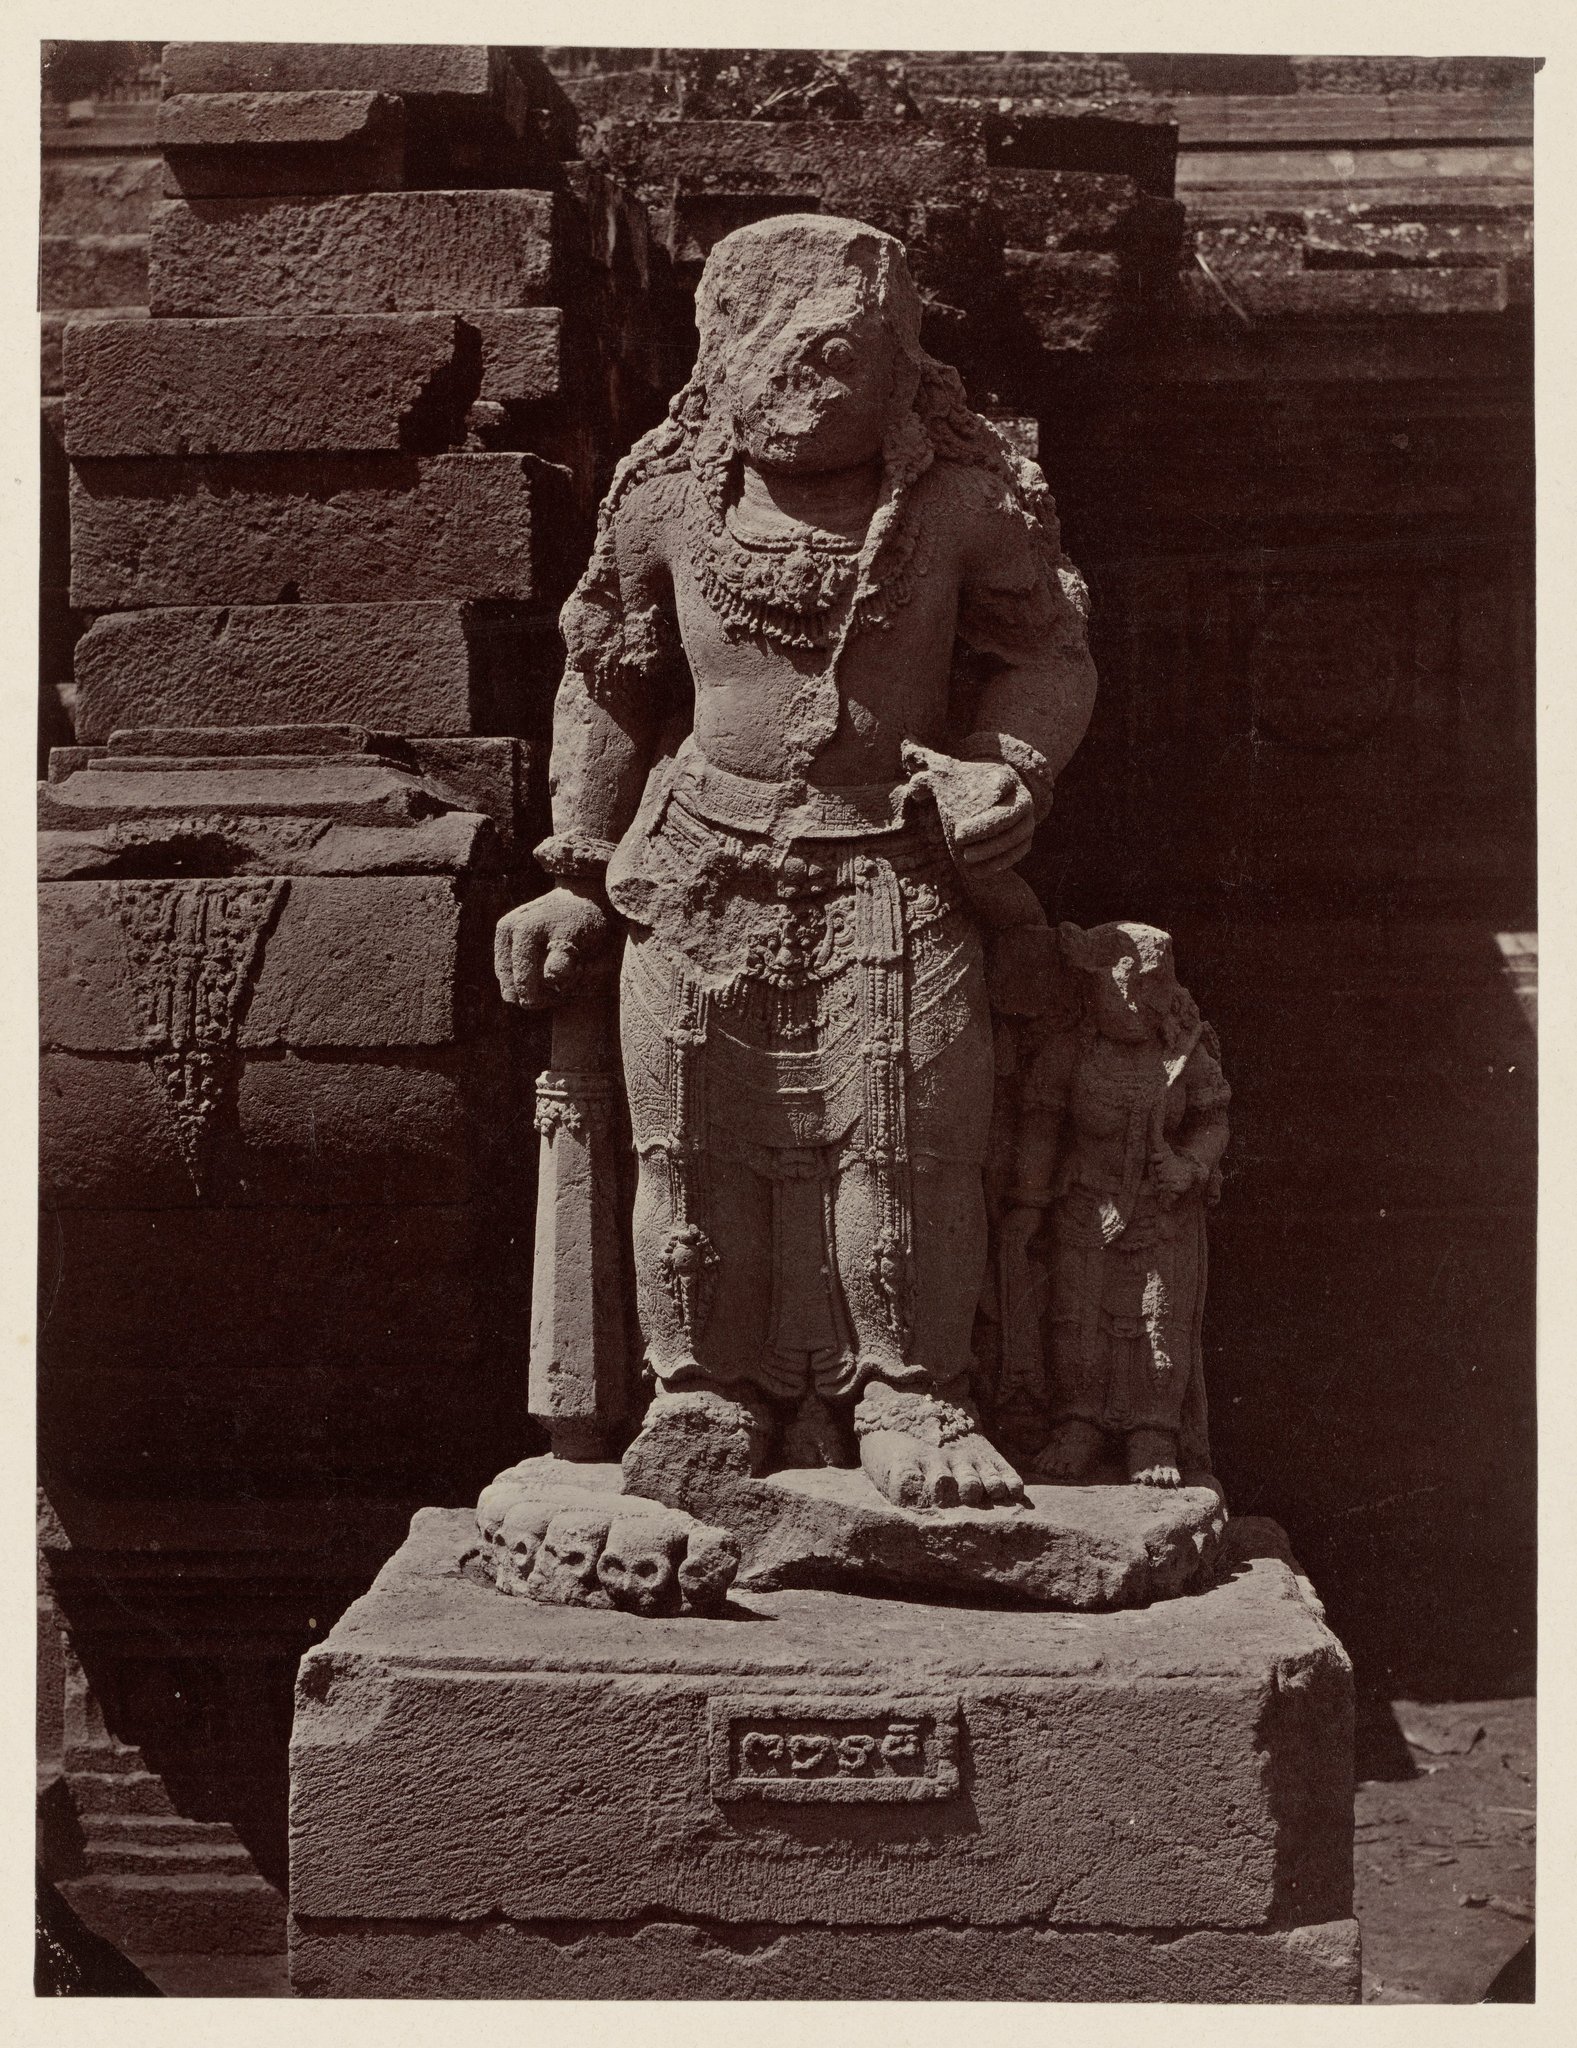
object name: photograph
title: Candi Panataran (Temple Complex), Main Temple; dated dvarapala (with female attendant) guarding the left staircase, Panataran, Blitar district, East Java province, 1323-1347 AD, Indonesia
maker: isidore kinsbergen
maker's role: fotograaf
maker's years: 1821-1905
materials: cardboard, paper, photographic support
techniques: albumen print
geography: java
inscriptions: title: ‘Siva als tempelwachter (?) staande voor den tempel te Panataran (Residentie Kediri) Cat. no. 249’